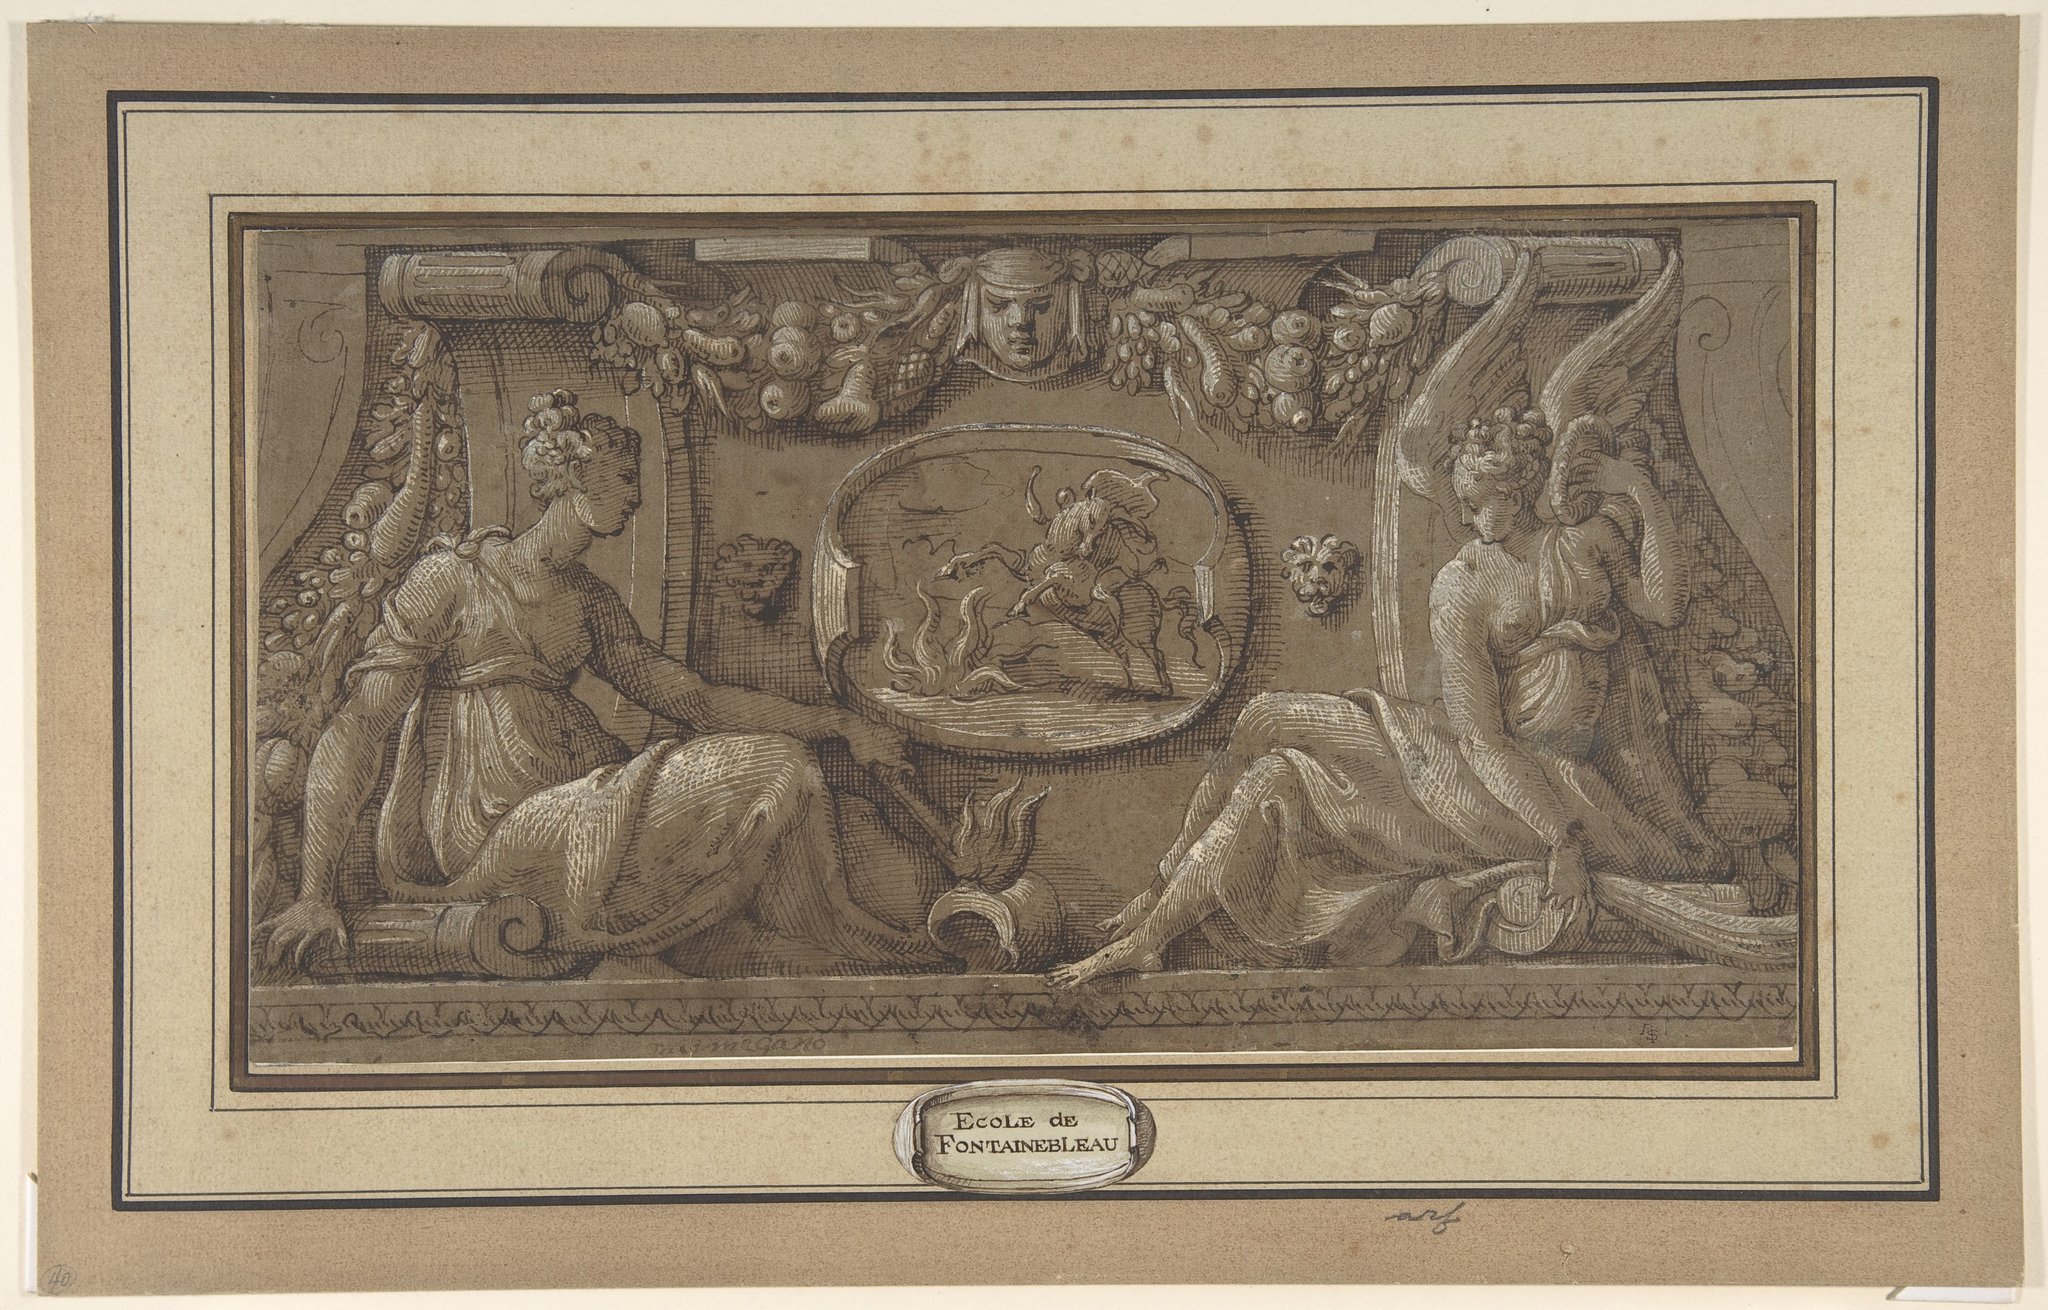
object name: drawing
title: Design for a Frieze in Fontainebleau Style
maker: anonymous, french, 19th century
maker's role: artist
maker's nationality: french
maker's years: 1800-1900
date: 1801-1900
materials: ink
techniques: heightening, pen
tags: women,horses